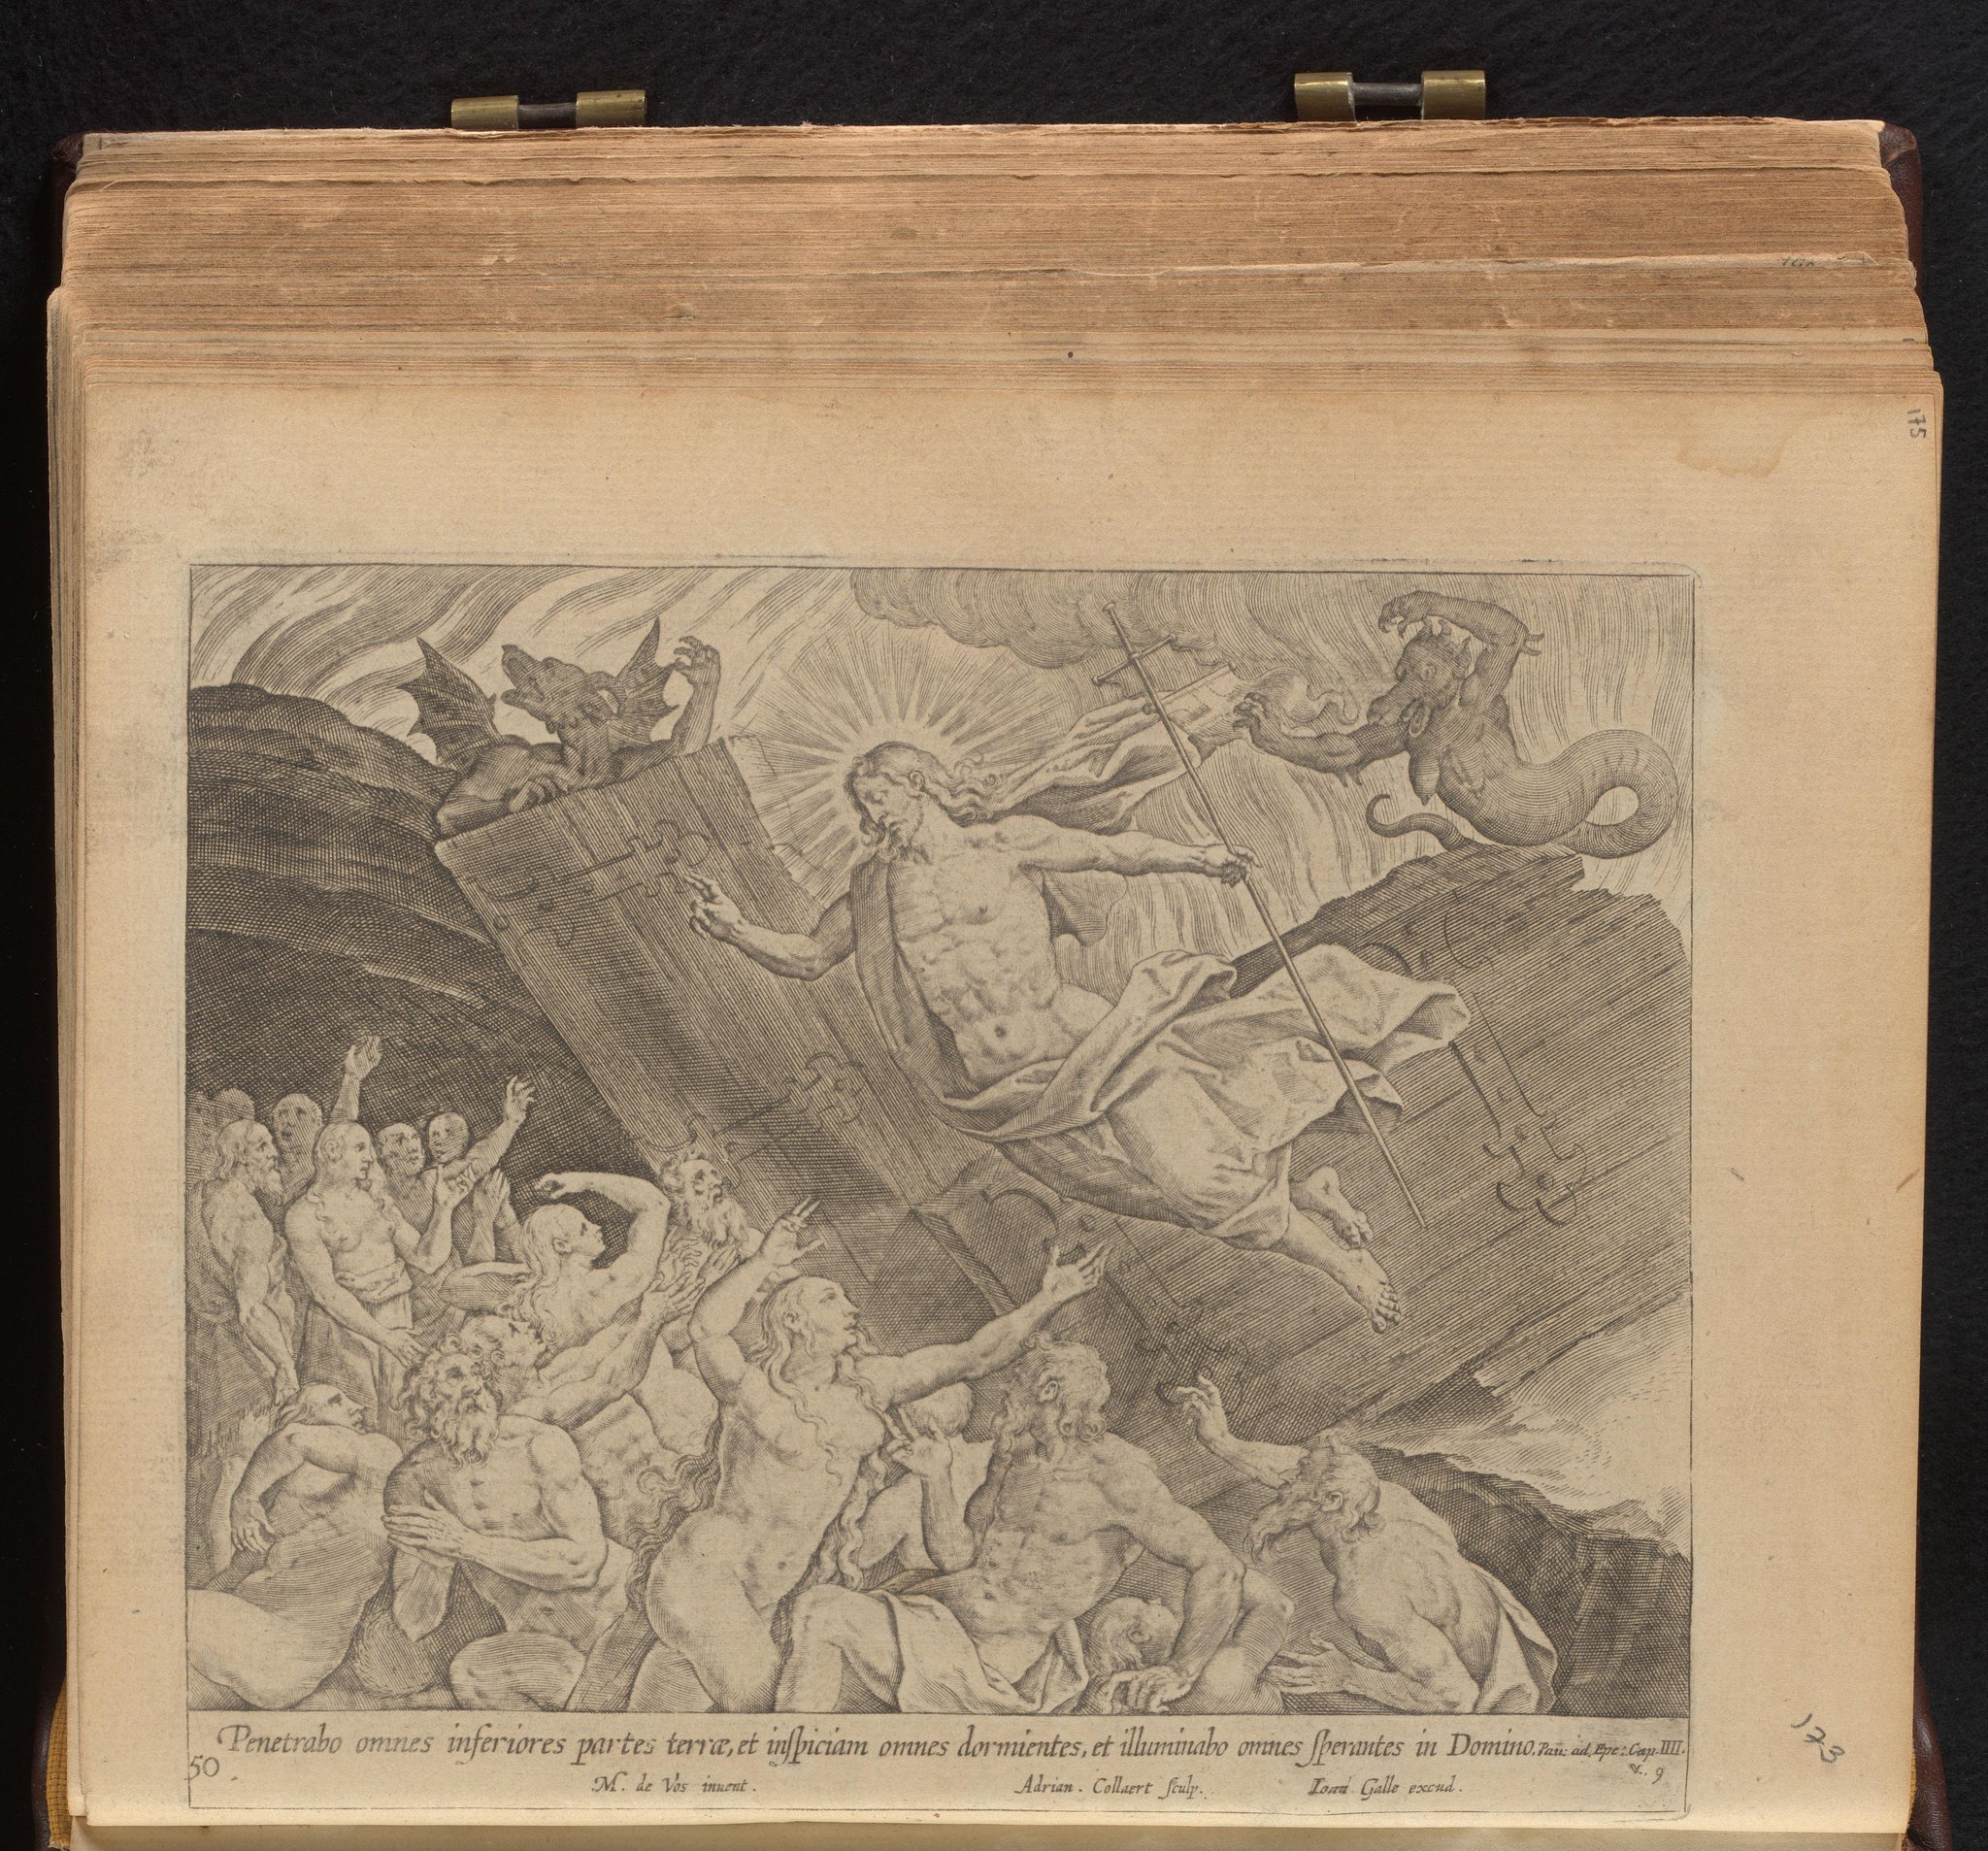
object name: print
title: Christus in het voorgeborchte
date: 1598-1618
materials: paper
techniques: engraving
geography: antwerp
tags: christ arrives at the entrance of hell and breaks the door(s)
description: Prent maakt deel uit van een prentbijbel.